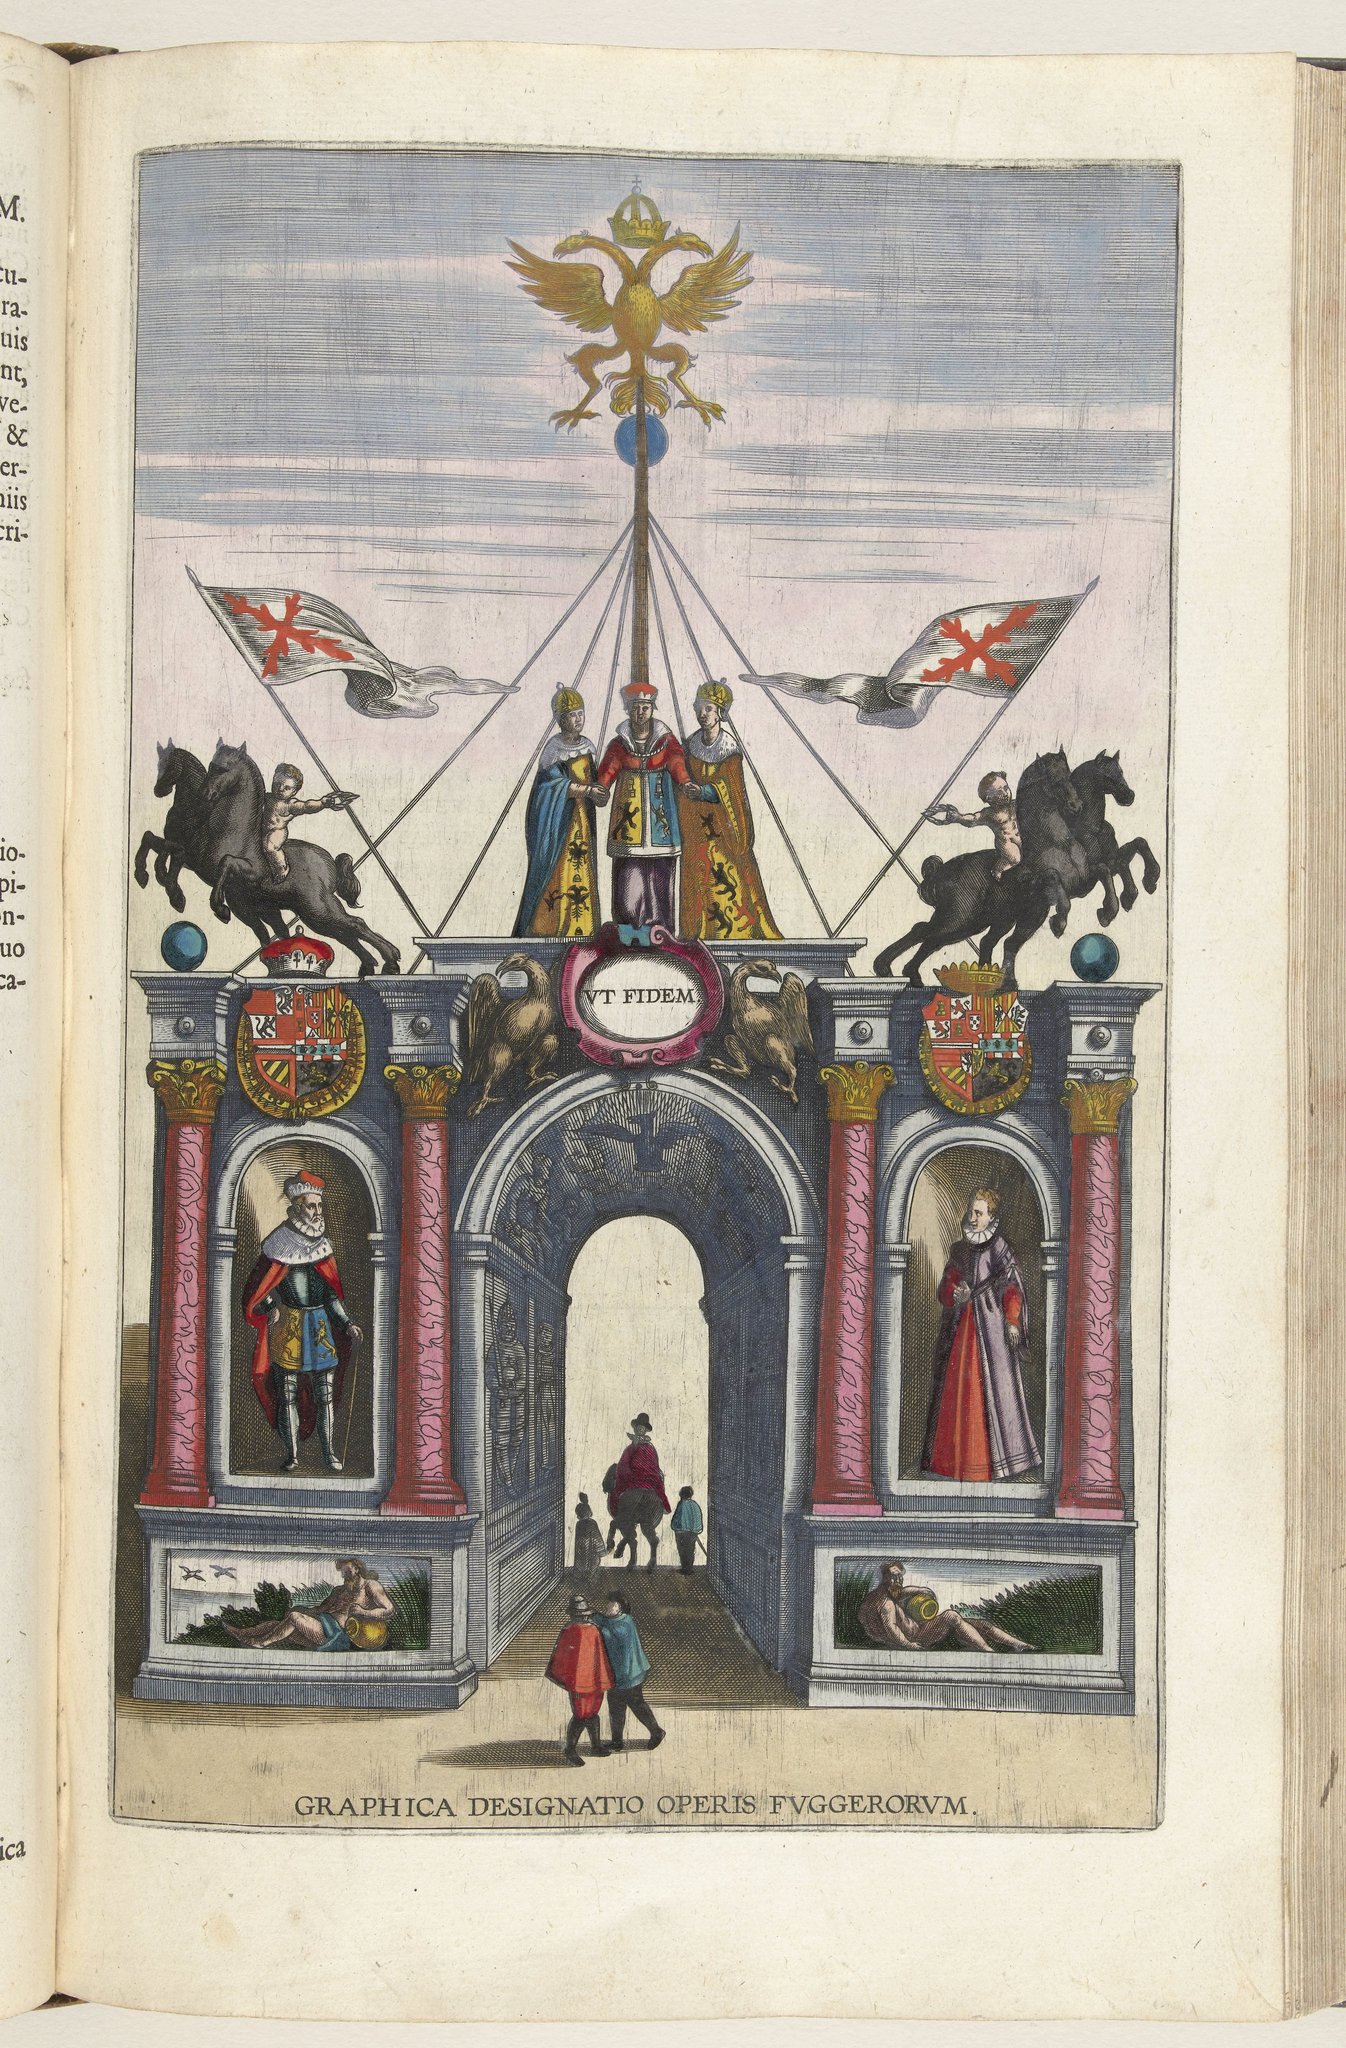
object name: print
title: Graphica designatio operis Fuggerorum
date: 1599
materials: paper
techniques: engraving, hand coloring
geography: antwerp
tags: infante van spanje isabella clara eugenia, brussels, albrecht aartshertog van oostenrijk, triumphal arch, triumphal entry and public reception, pageant, 'entrée solennelle', 'joyeuse entrée', antwerp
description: Triomfpoort van de familie Fugger, december 1599. Triomfpoort versierd met afbeeldingen van historische vorsten. Tijdens de intocht te Antwerpen. Onderdeel van: Historica narratio profectionis et inaugurationis serenissimorum Belgii principum Alberti et Isabellae Austriae archiducum, de beschrijving van de intochten van het paar te Brussel, Antwerpen, Gent en Valenciennes, 1599.